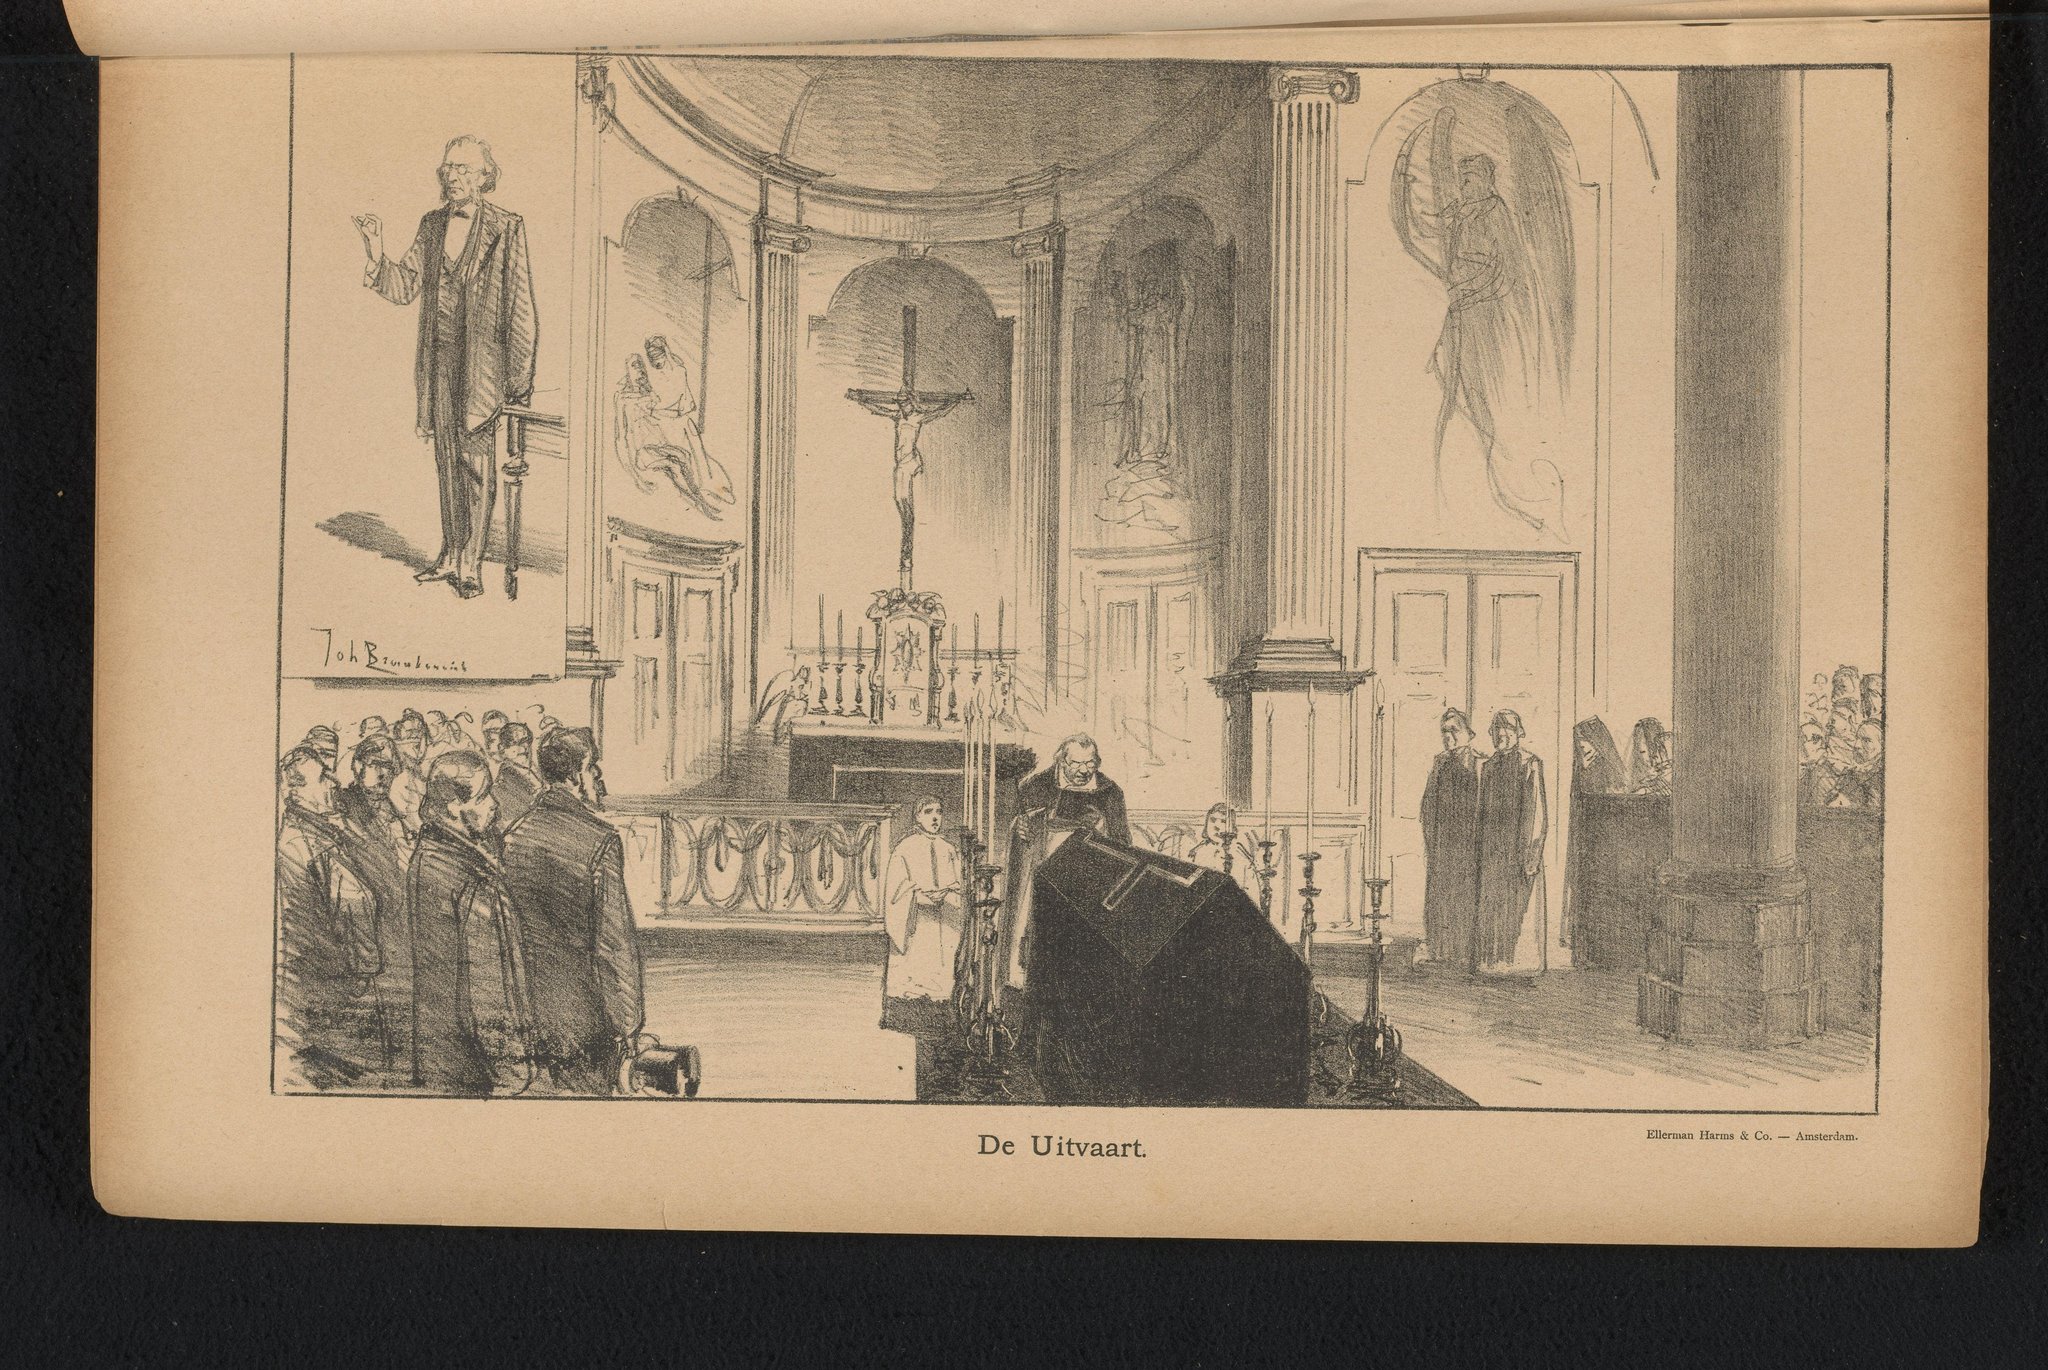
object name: print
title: De Uitvaart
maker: johan braakensiek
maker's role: draughtsman, print maker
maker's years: 1858-1940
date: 1889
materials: paper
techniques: lithograph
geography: netherlands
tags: amsterdam, painter, draughtsman, publisher, josephus albertus alberdingk thijm, historical persons, interior of church, funerary ceremonial, writer, poet, author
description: Kerkinterieur met de uitvaart van de schrijver en letterkundige Joseph Alberdingk Thijm, overleden 17 maart 1889. Linksboven een inzet met een portret.